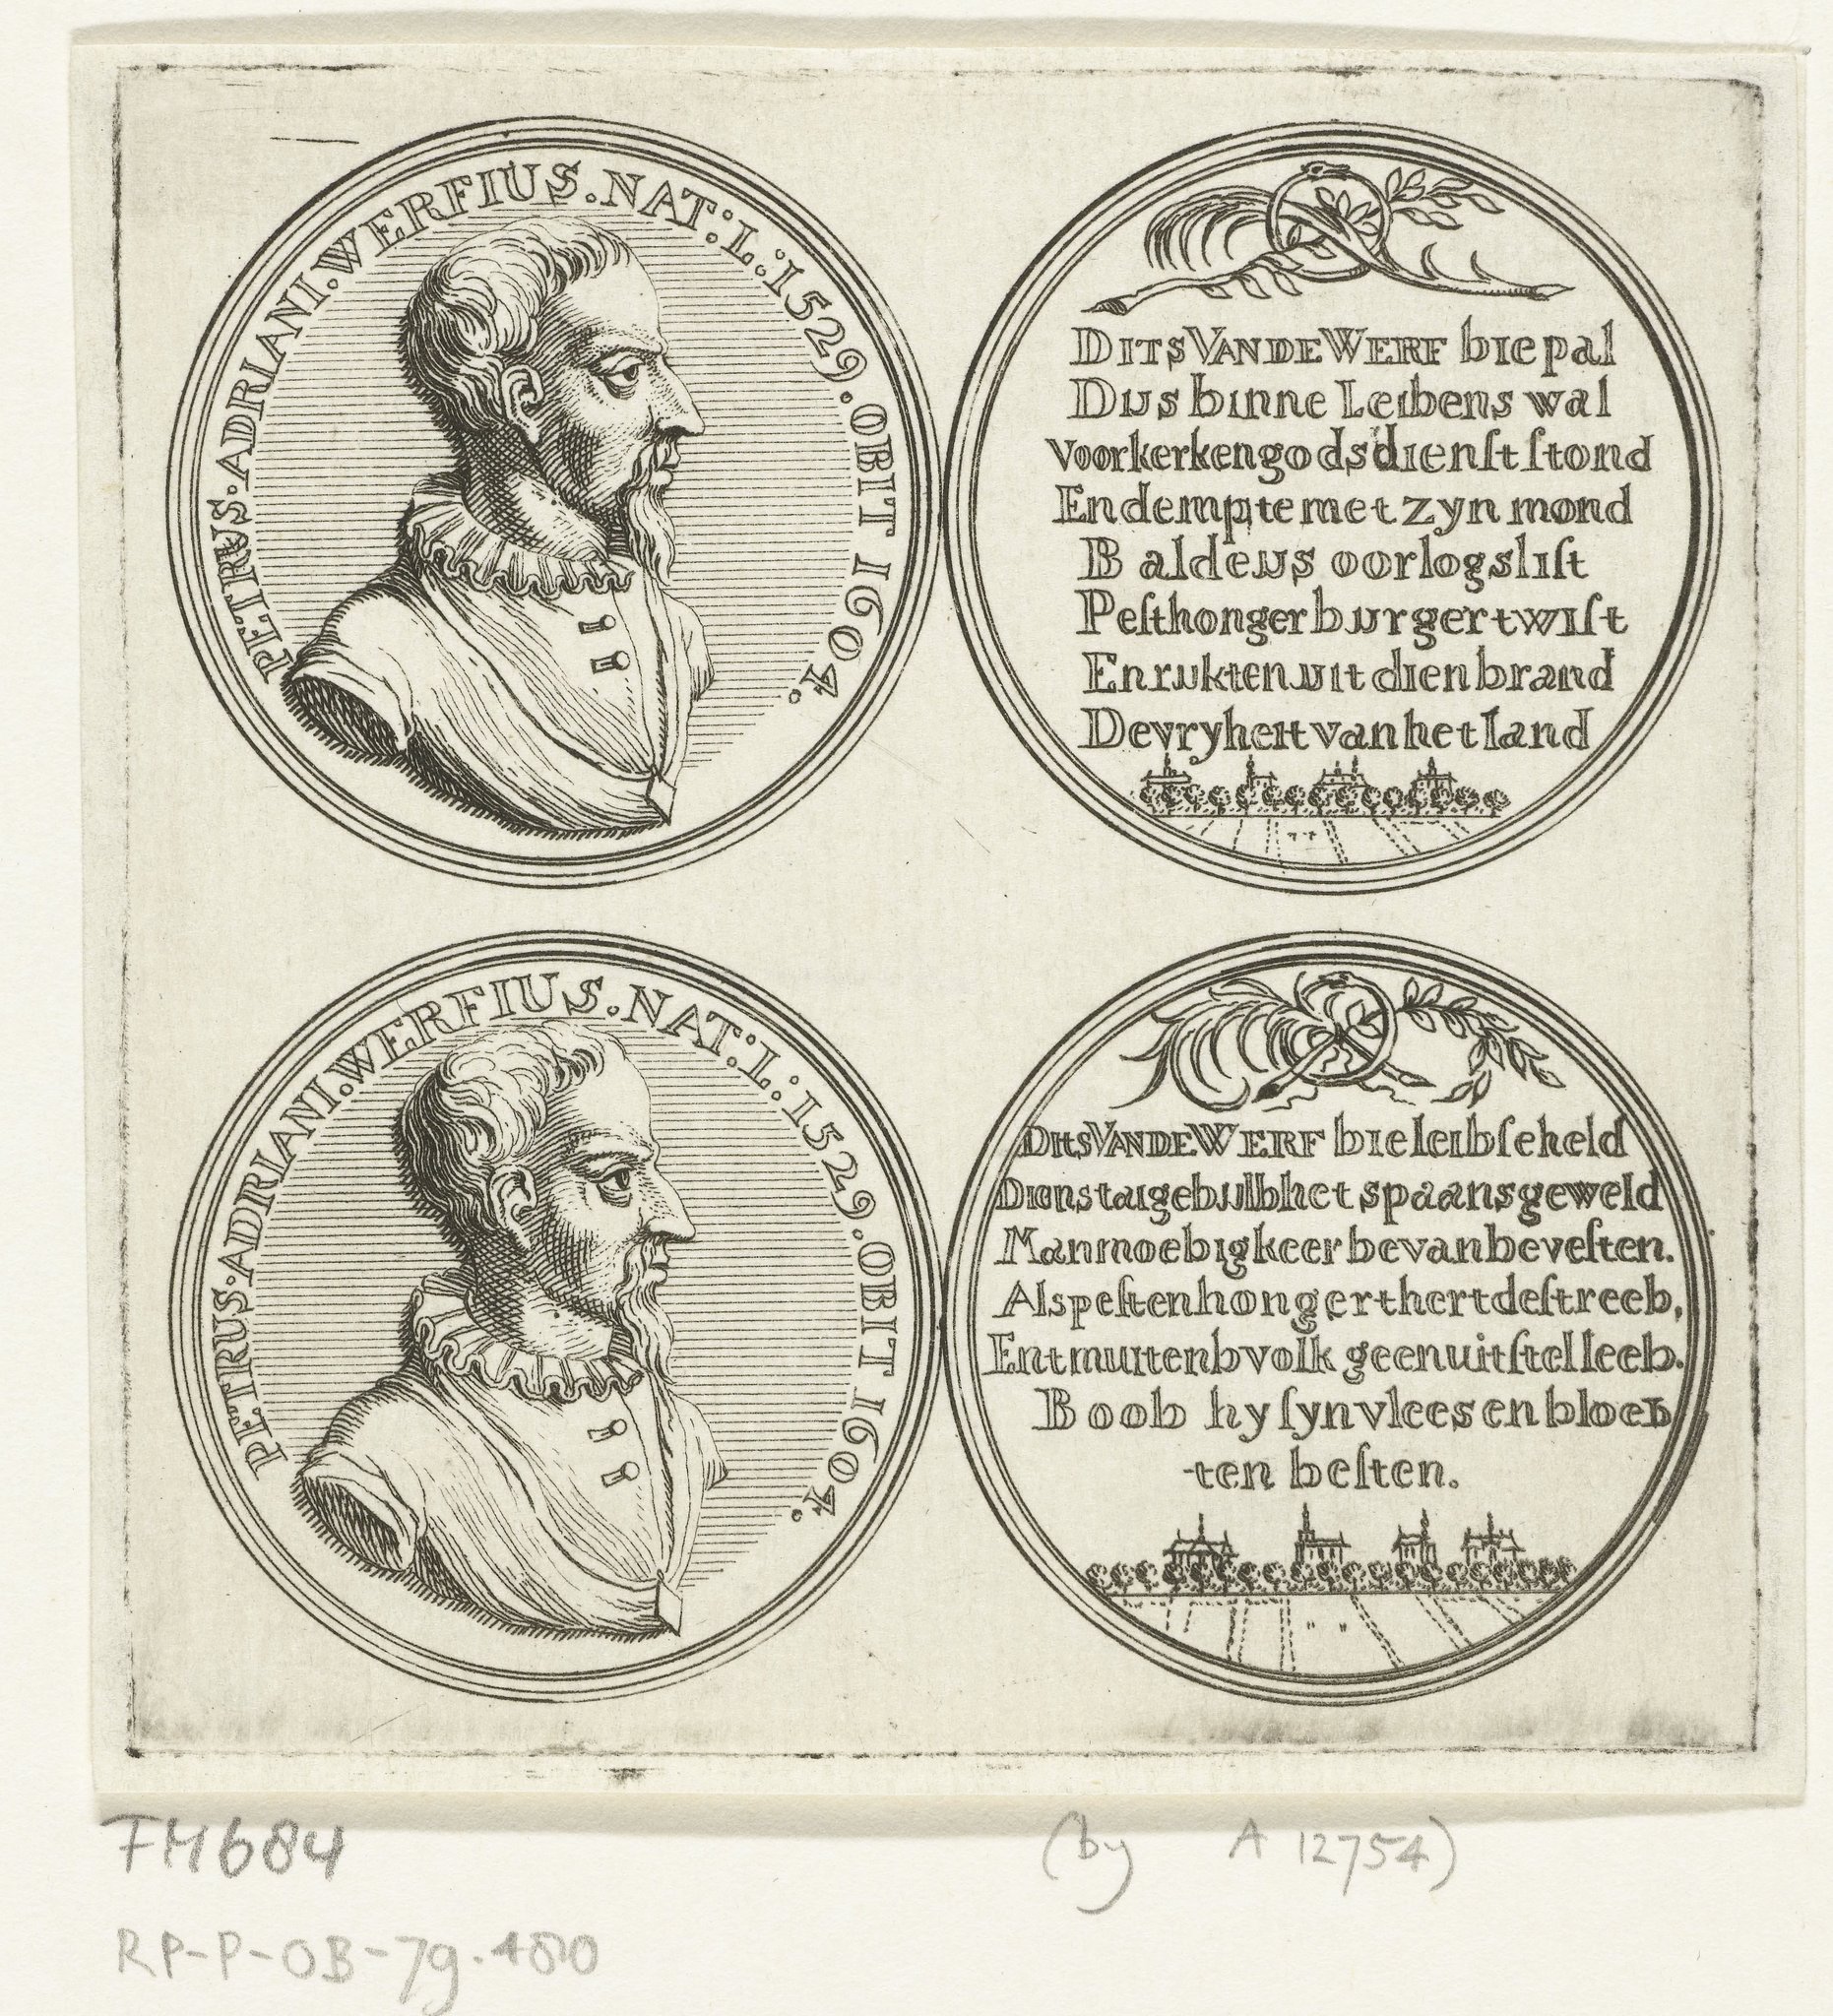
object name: historical object representation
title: Twee penningen ter ere van burgemeester Pieter van der Werff, 1604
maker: Anonymous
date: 1700-1749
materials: paper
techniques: etching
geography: netherlands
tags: mayor, medal (considered as a piece of sculpture, regardless of its specific function), leiden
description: Twee penningen met portret van burgemeester Pieter Adriaansz. van der Werff, bij zijn overlijden in 1604. Voorzijde: borstbeeld van Van der Werff binnen omschrift. Keerzijde: vers boven gezicht op Leiden.